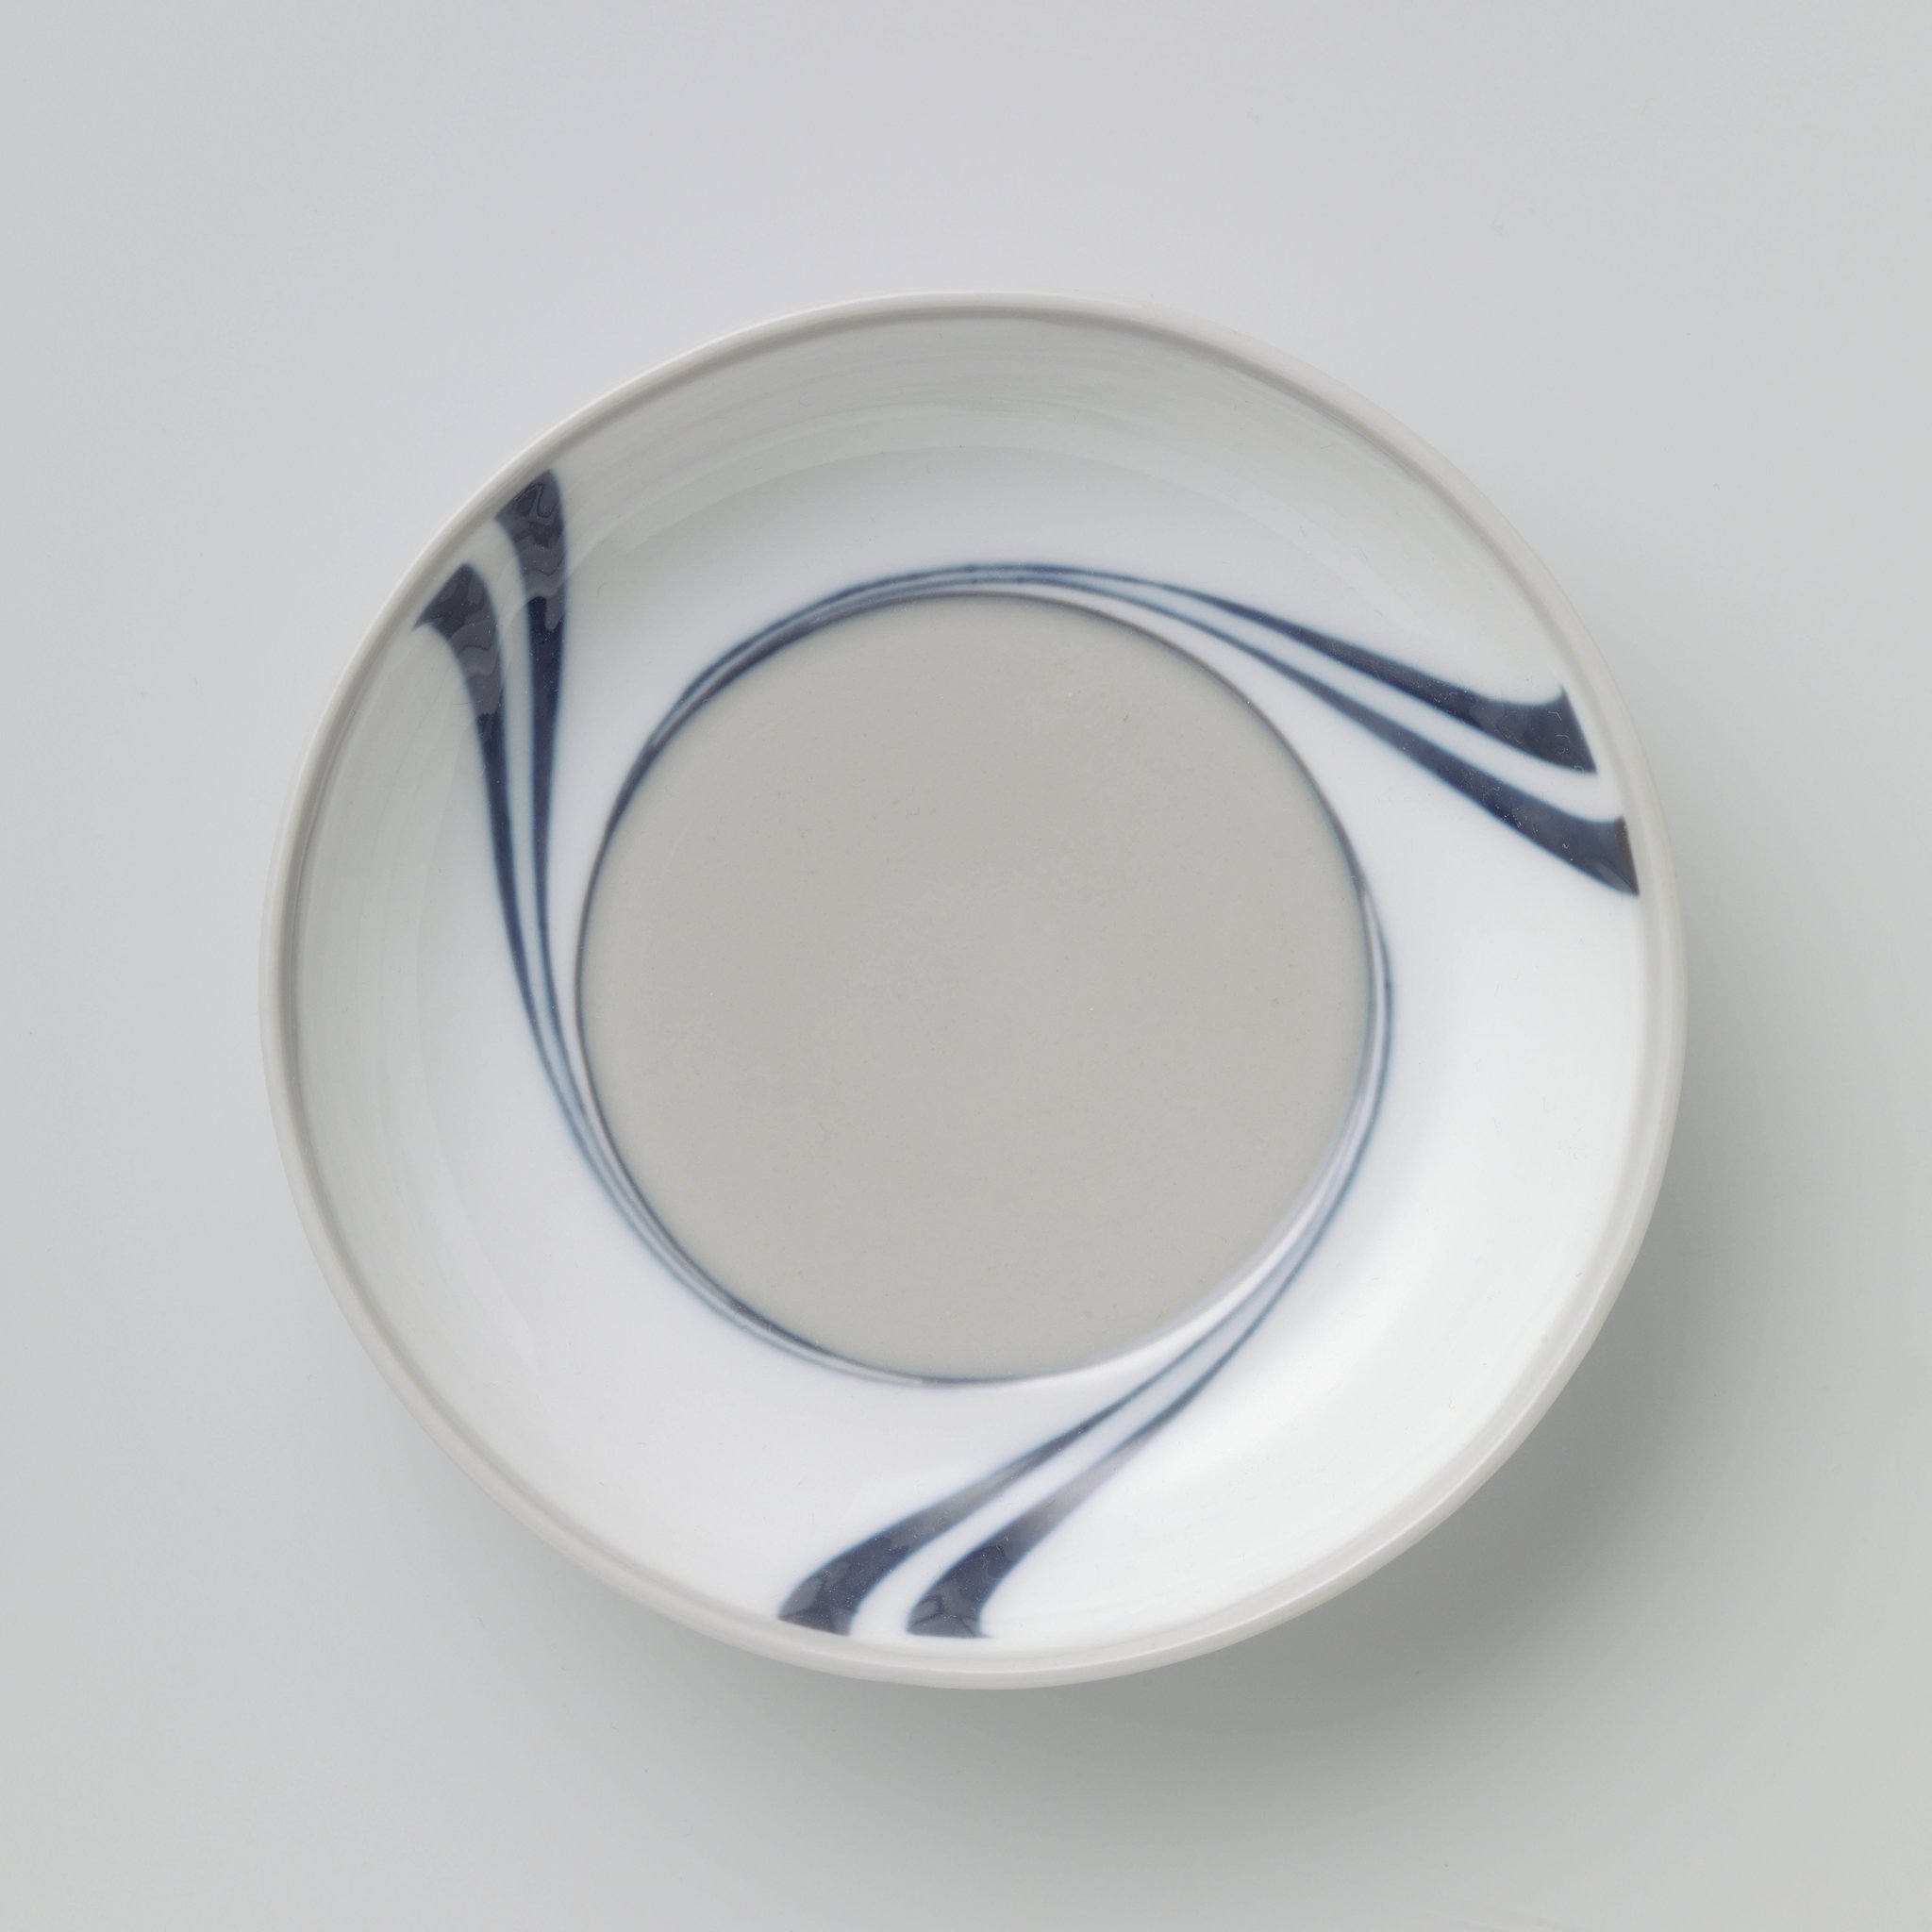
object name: eating drinking utensil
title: Schotel uit het koffie- en theeservies 'Saxonia'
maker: otto eduard voigt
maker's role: keramiekontwerper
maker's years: 1870-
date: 1904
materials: porcelain, chemical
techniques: painted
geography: meissen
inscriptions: factory mark, mark: ‘66 (of 99)’, model number: ‘U 127’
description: Schotel van porselein, beschilderd in blauw en grijs. De schotel hoort bij het koffie- en theeservies Saxonia. De schotel is gemerkt.